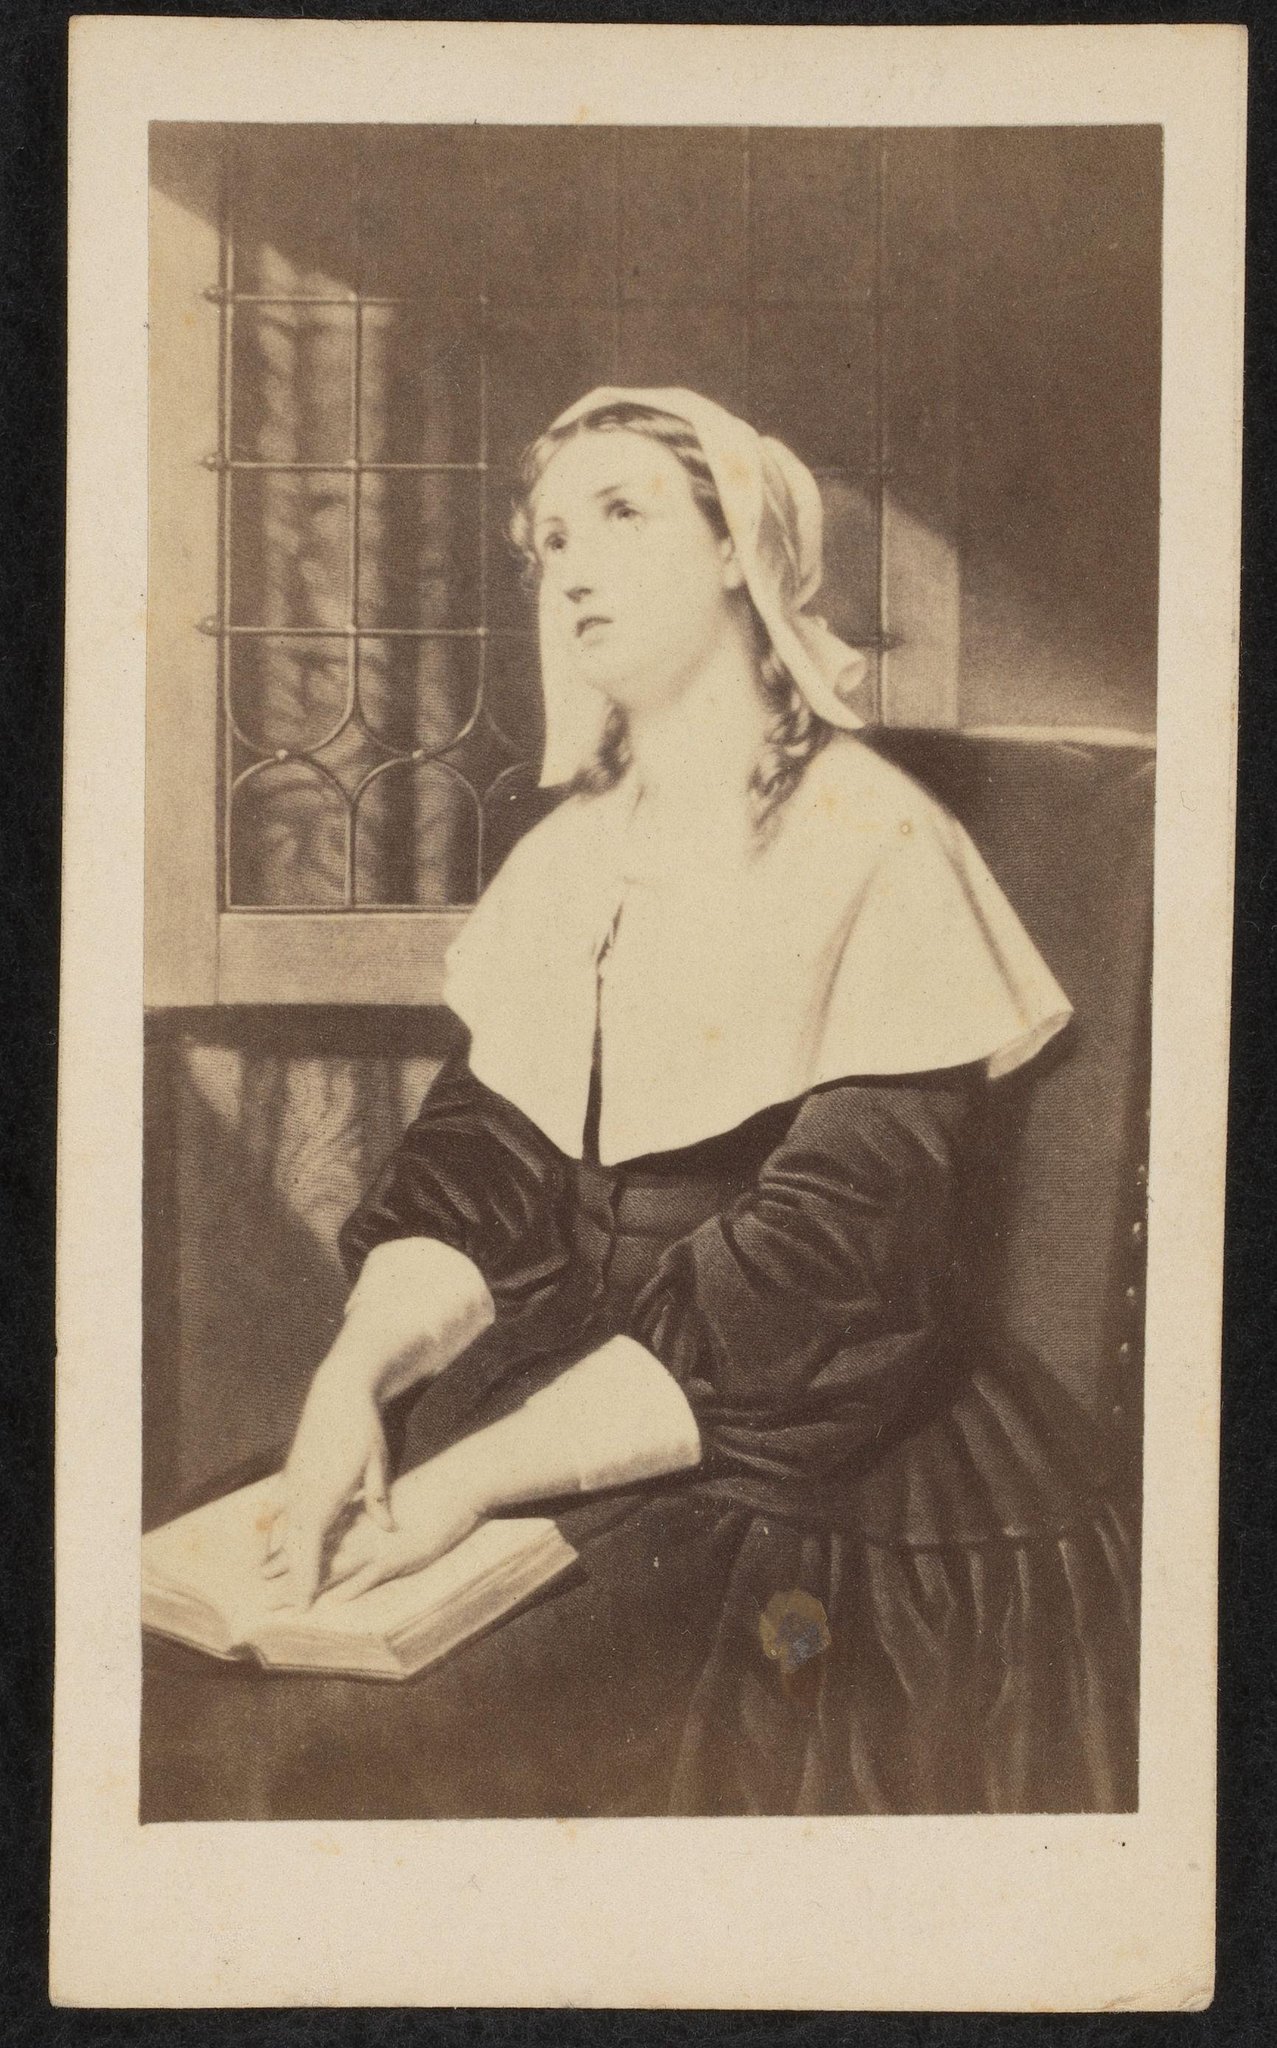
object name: carte de visite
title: Fotoreproductie van een schilderij, gezeten vrouw met open boek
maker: Anonymous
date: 1860-1900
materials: cardboard, photographic support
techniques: albumen print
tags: adolescent, young woman, maiden, sitting figure, book - mm - book open